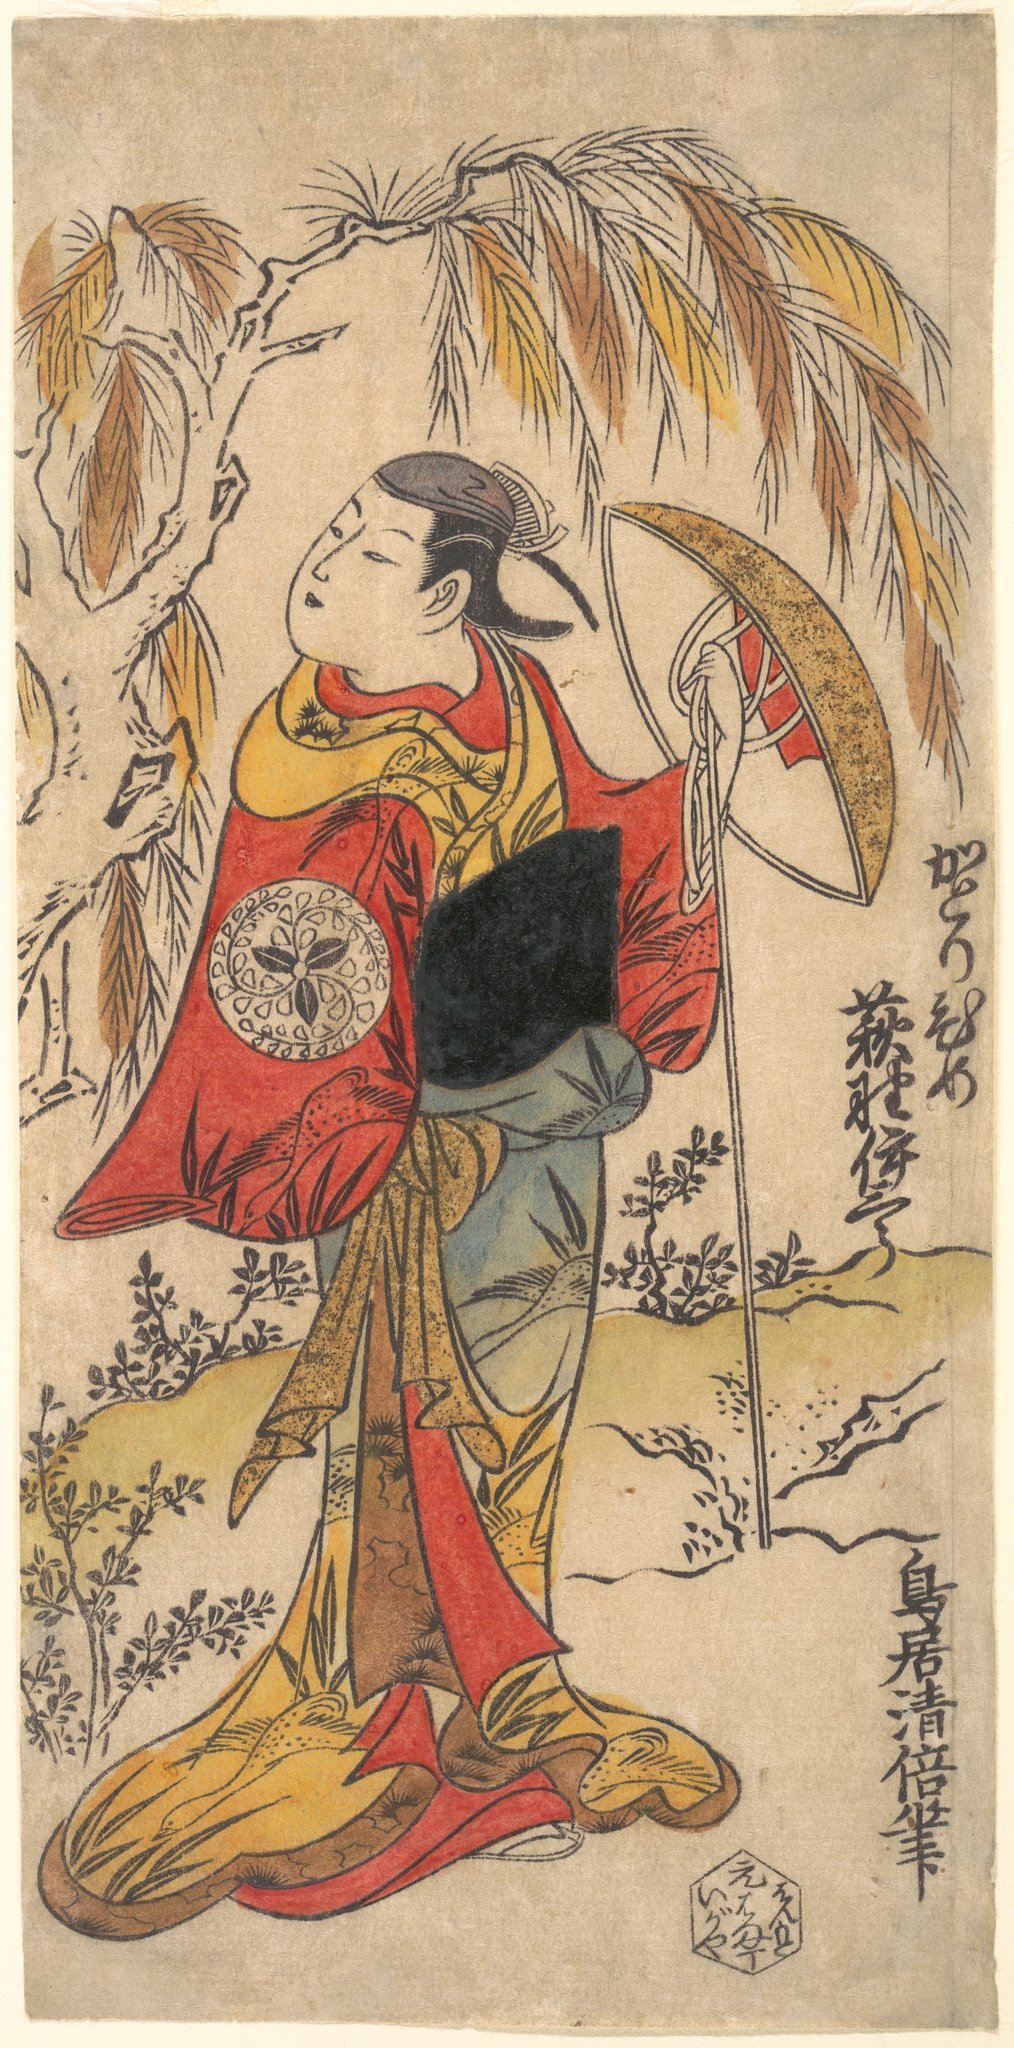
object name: print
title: The Actor Ogino Isaburō in the Role of Katorihime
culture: japanese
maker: torii kiyomasu i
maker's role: artist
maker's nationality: japanese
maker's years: 1696-1716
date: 1734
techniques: urushi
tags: men,actors